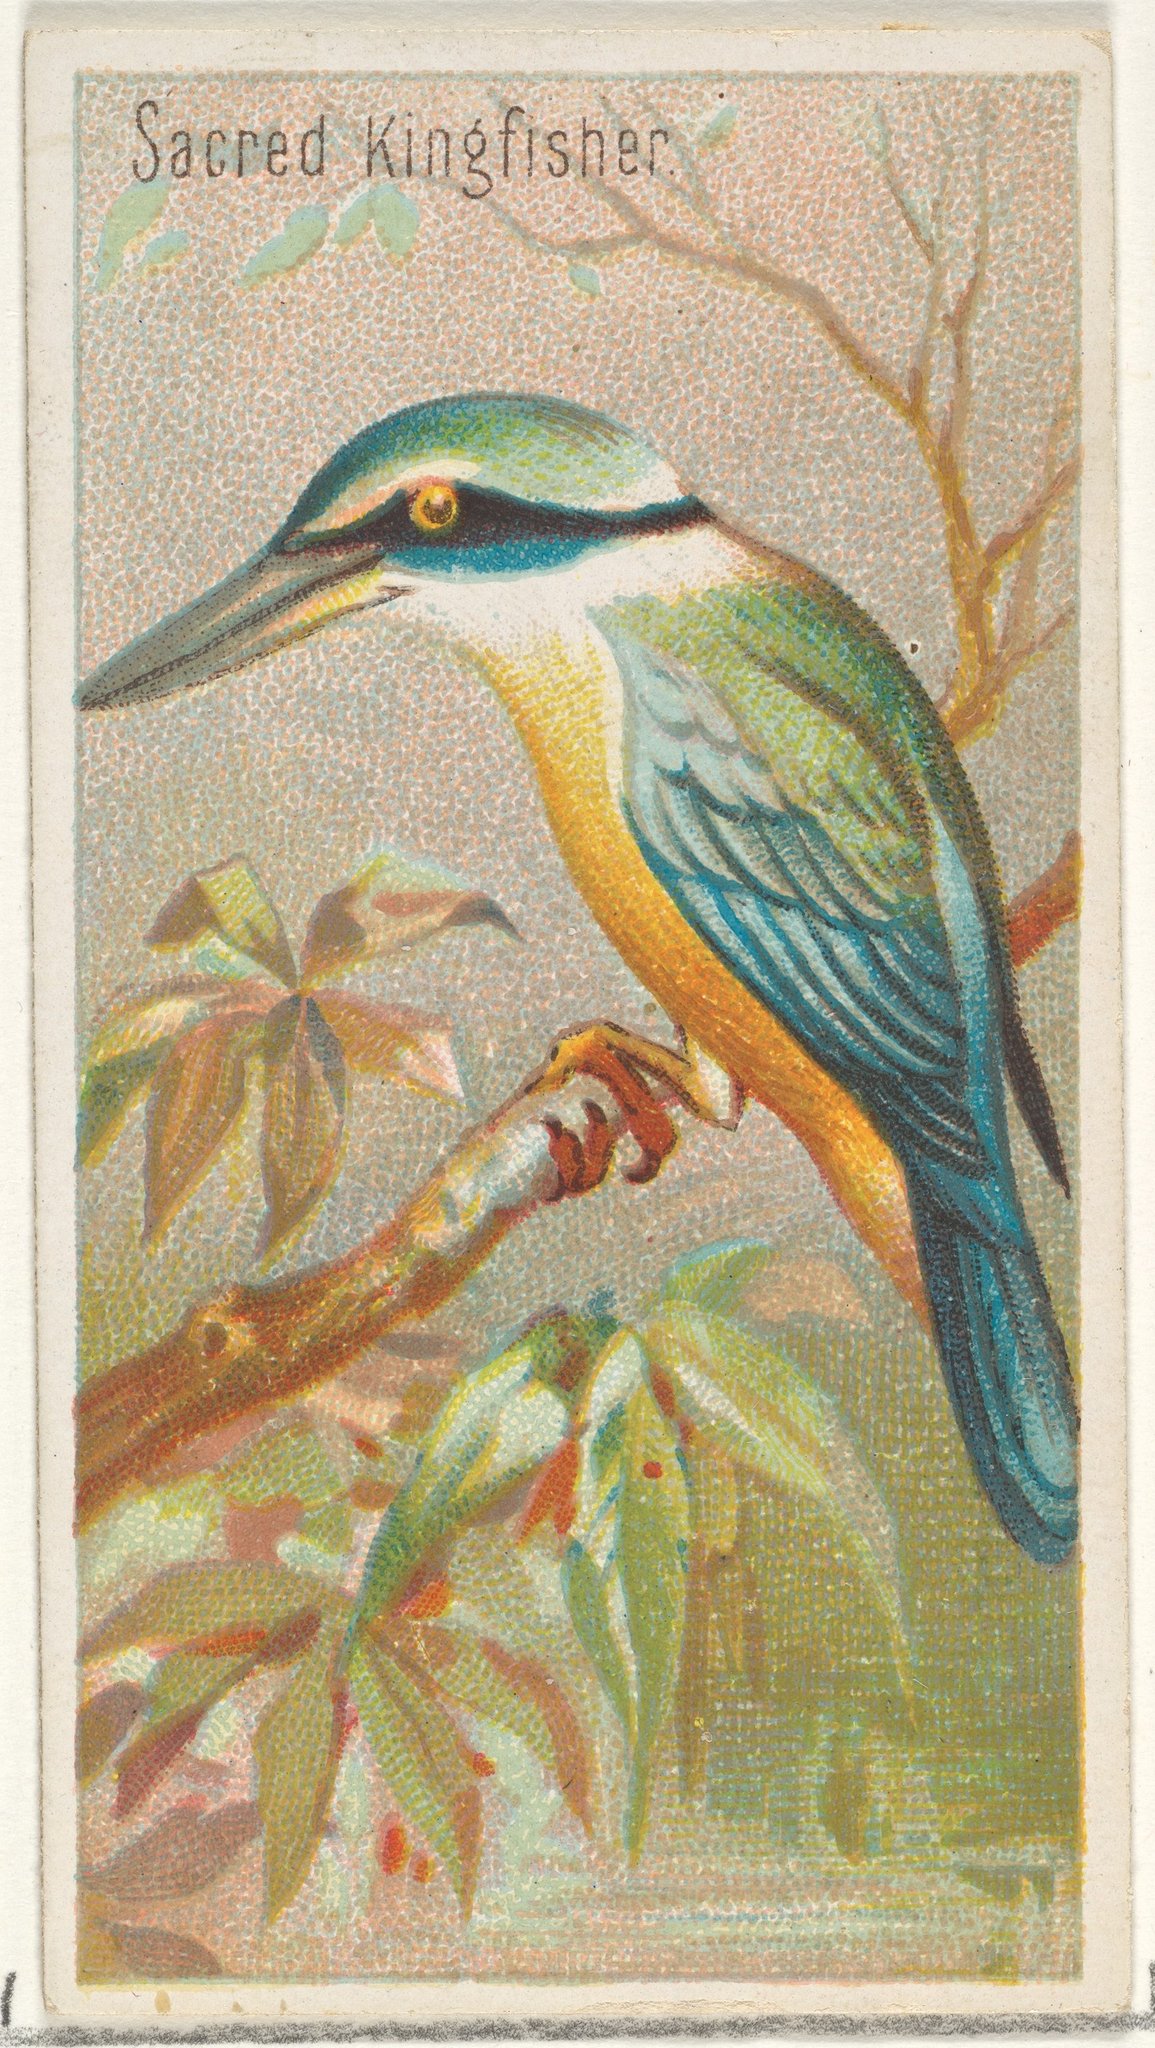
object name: print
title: Sacred Kingfisher, from the Birds of the Tropics series (N5) for Allen & Ginter Cigarettes Brands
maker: allen & ginter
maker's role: publisher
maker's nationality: american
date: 1889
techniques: color lithograph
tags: birds